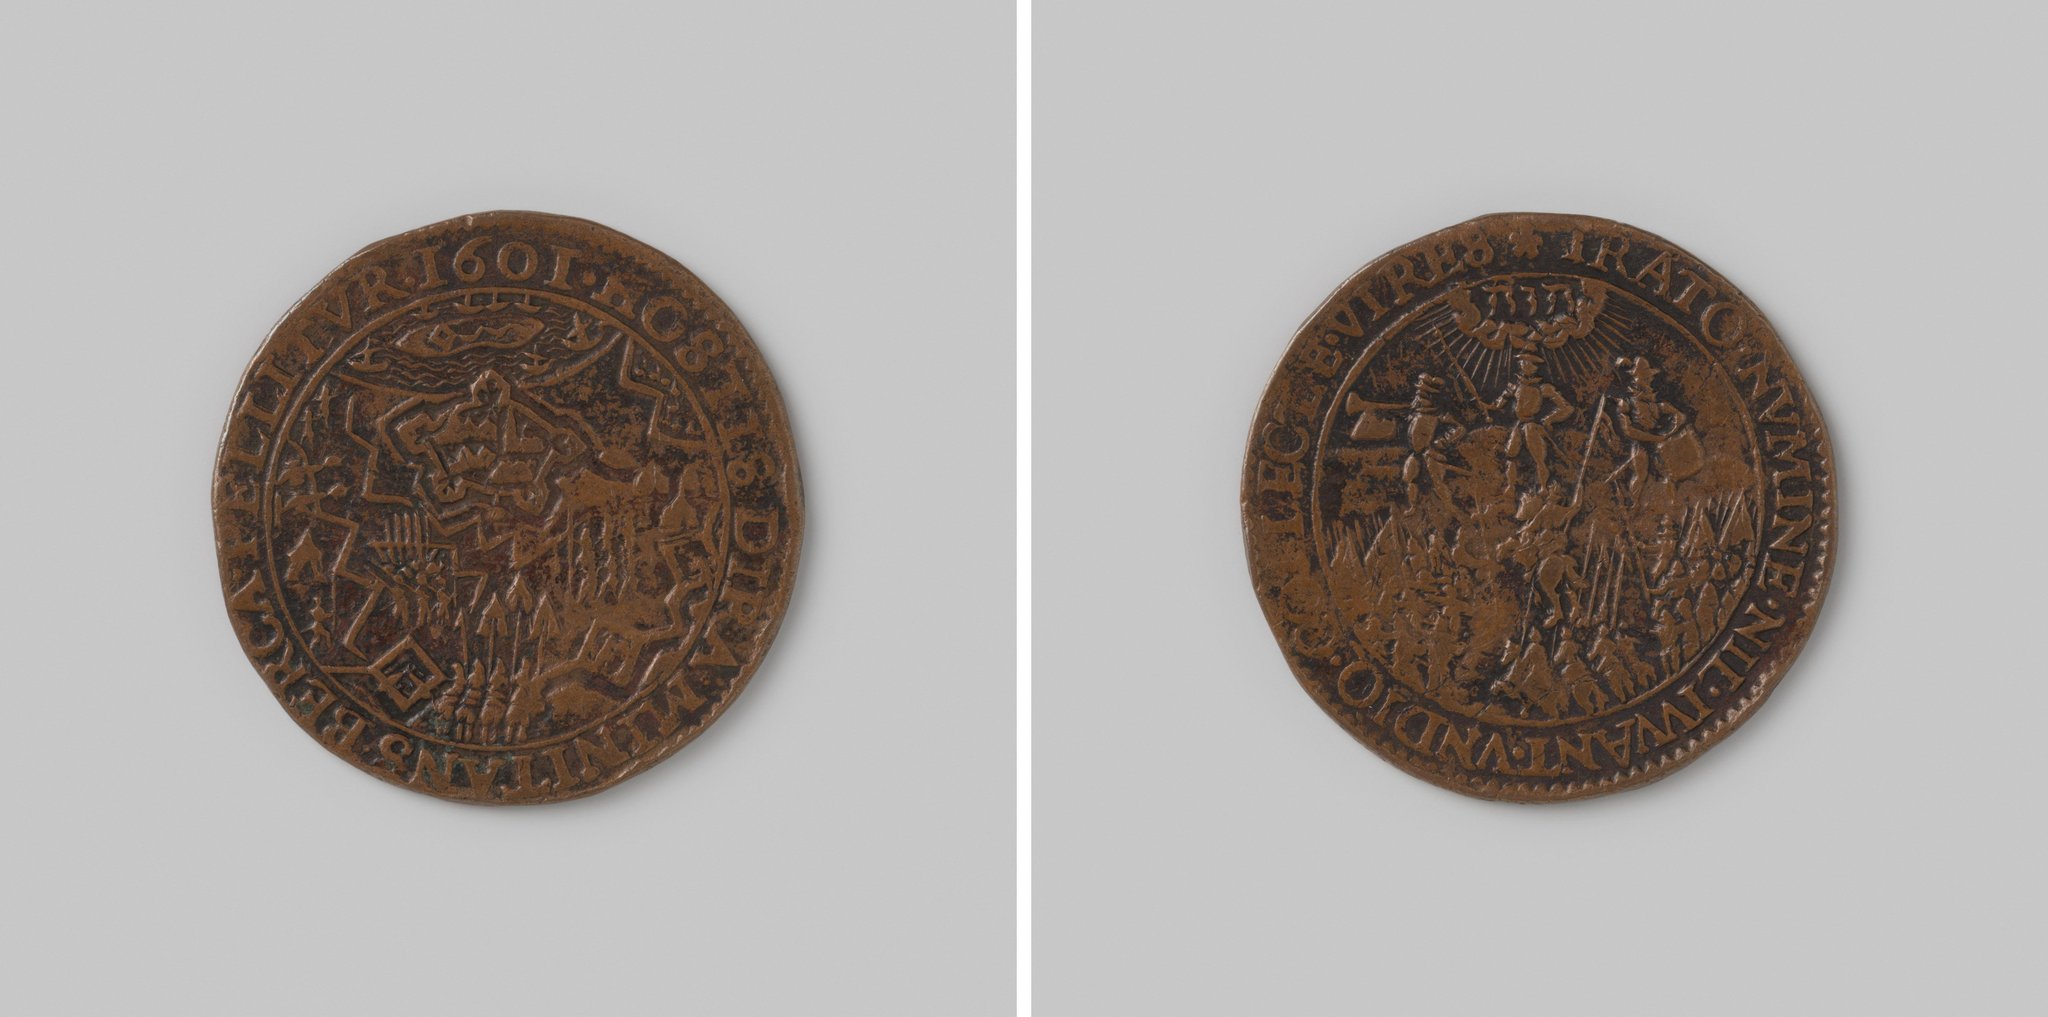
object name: history medal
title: Rekenpenning uit Dordrecht (?) op de inname van Rijnberk door Prins Maurits 1601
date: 1601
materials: copper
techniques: striking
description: Koperen penning, op de voorzijde een plattegrond met Rijnberk met het leger van Maurits, met omschrift, op de keerzijde de Graaf van Berg met trompetter en trommelslager voor zijn troepen, onder de stralende naam Gods, met omschrift.